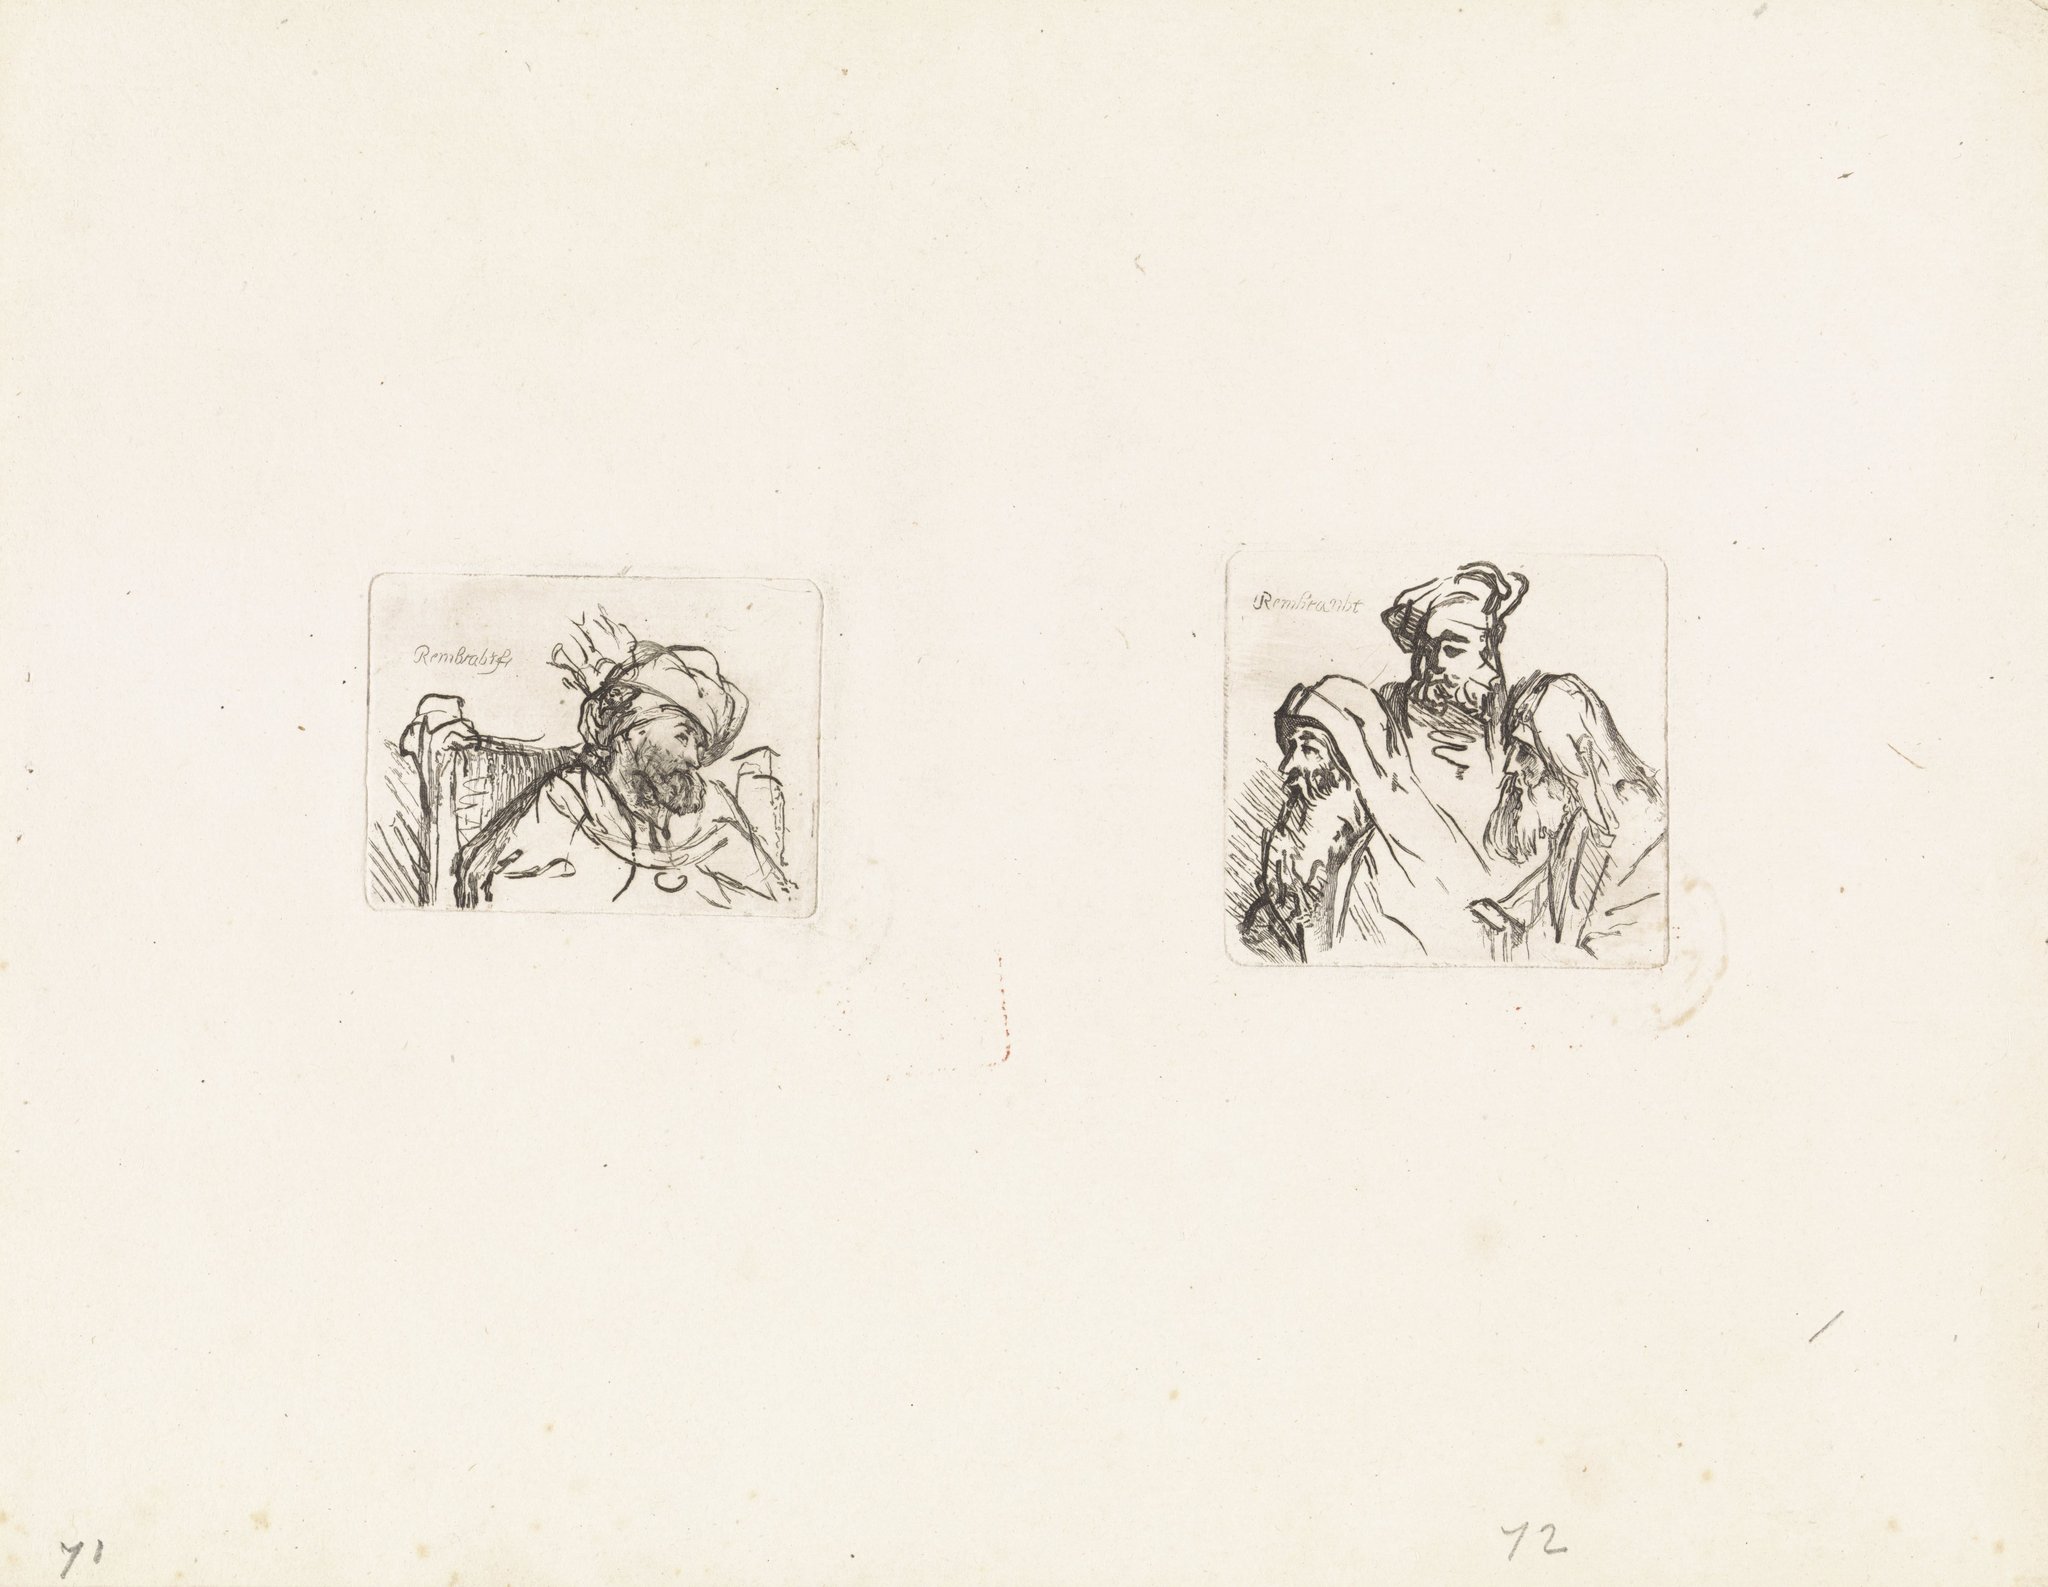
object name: print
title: Verscheide gedagten in het koper gebragt naar de origenelen teekeningen en schetschen van Rembrandt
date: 1696-1727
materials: paper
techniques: engraving, etching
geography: amsterdam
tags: beard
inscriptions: collector's mark: Lugt 240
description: Onversneden blad met twee voorstellingen van mannen. Links: Buste van een man op een stoel. Rechts: Een groep van drie mannen met baarden.